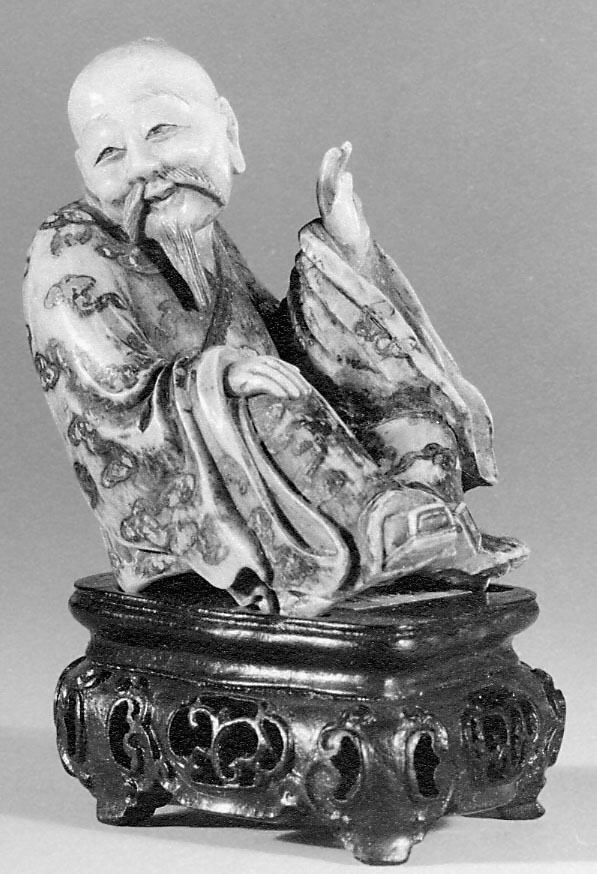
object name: statuette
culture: chinese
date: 1867-1900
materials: ivory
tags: men